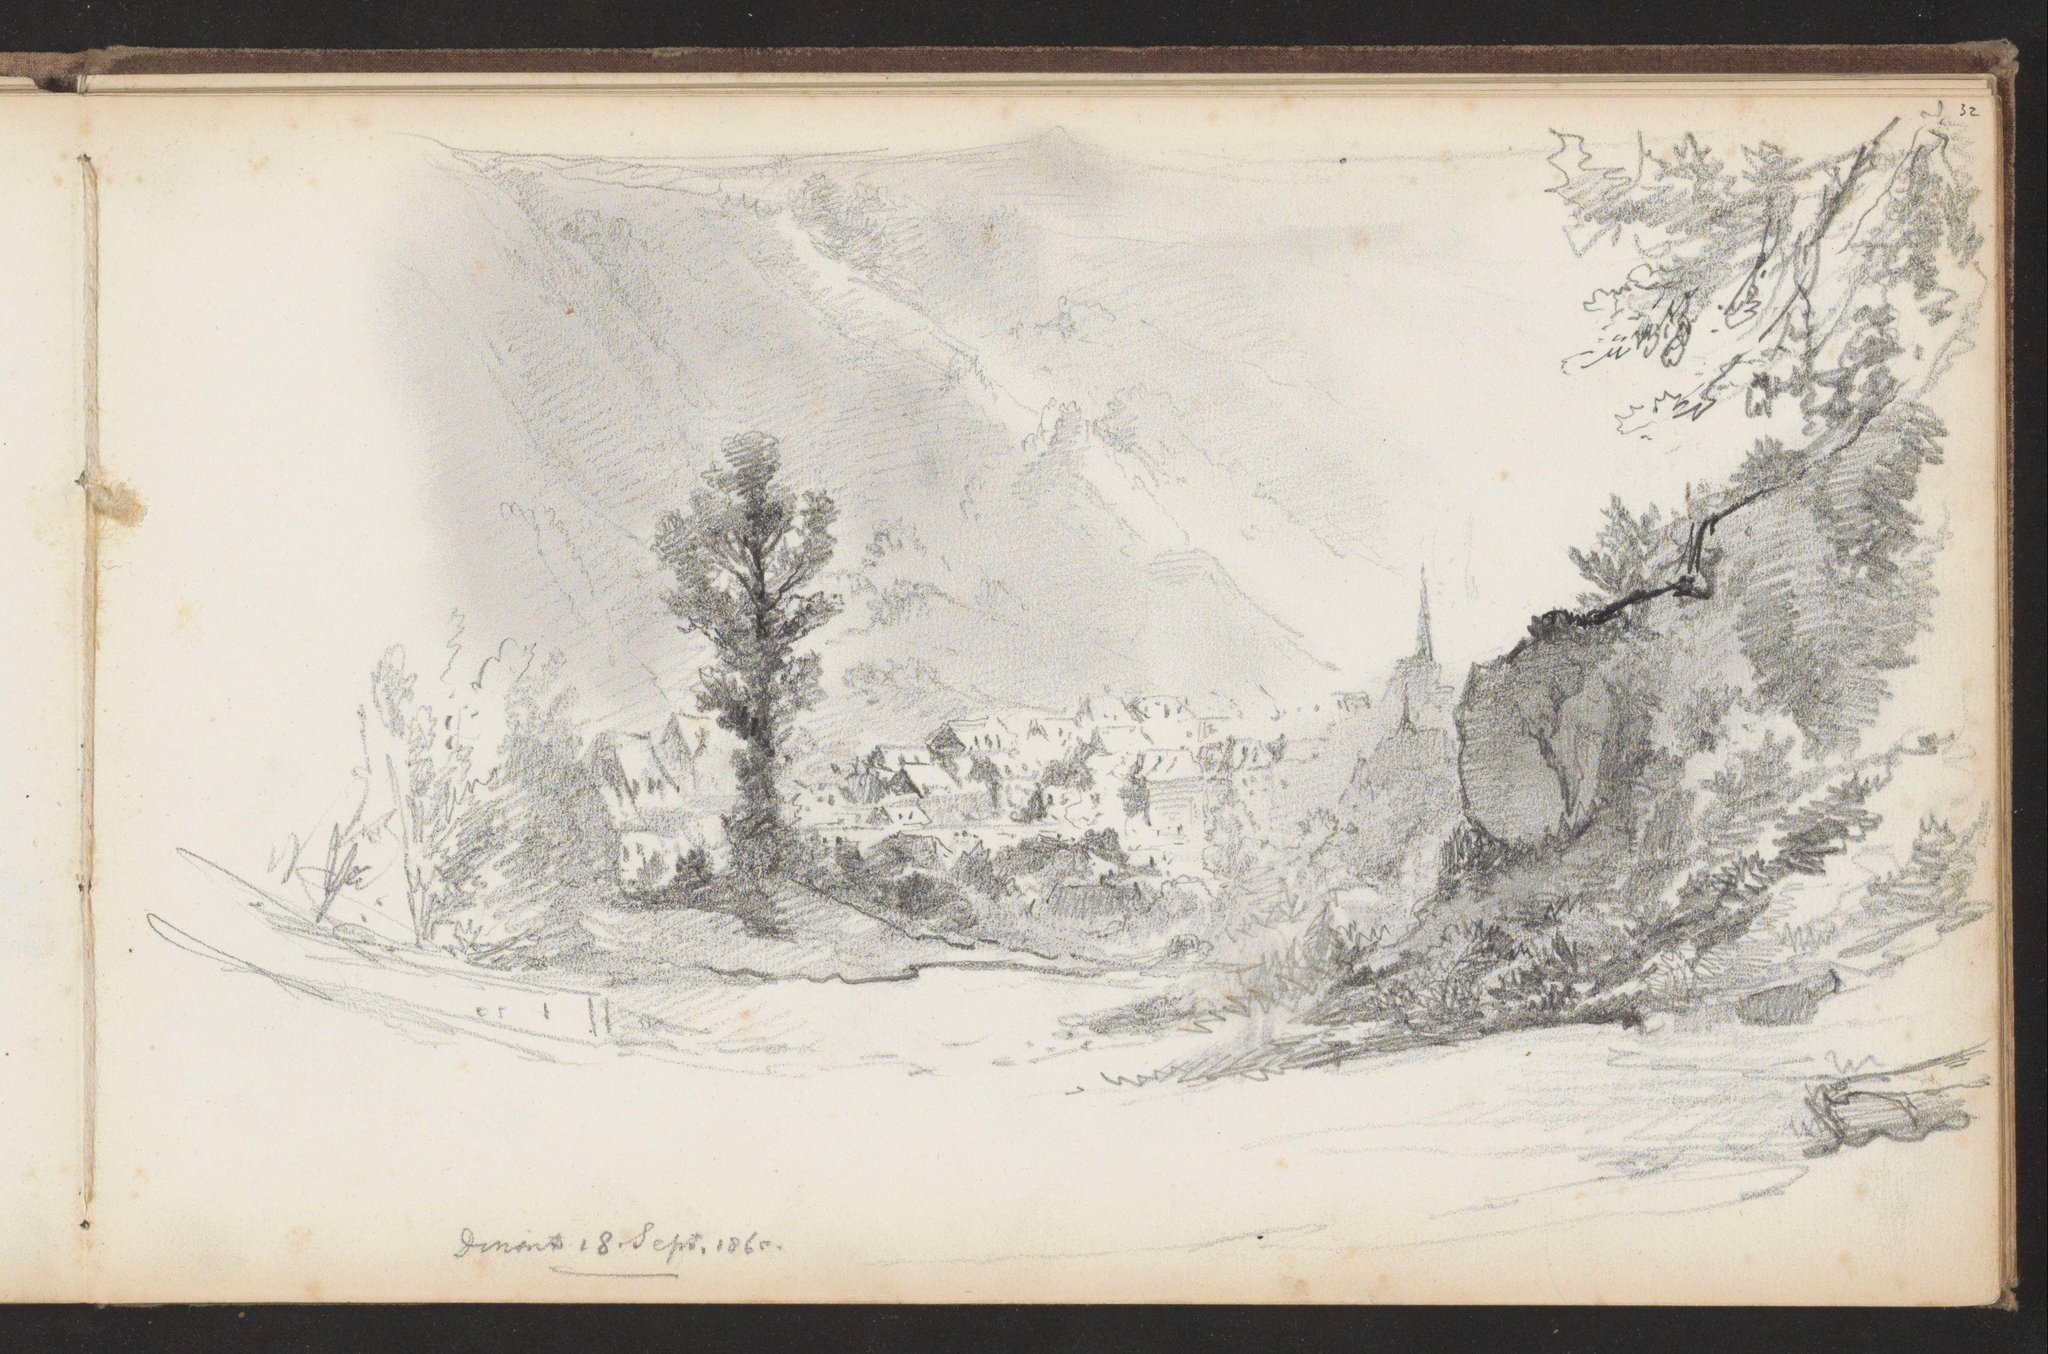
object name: sketchbook leaf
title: Gezicht op Dinant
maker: maria vos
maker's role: draughtsman, painter, print maker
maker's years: 1824-1906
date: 1809-1865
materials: paper, pencil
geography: dinant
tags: city-view, and landscape with man-made constructions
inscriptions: date and inscription: ‘Dinant 18 Sept. 1865.’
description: Blad 32 recto uit een schetsboek met 55 bladen.